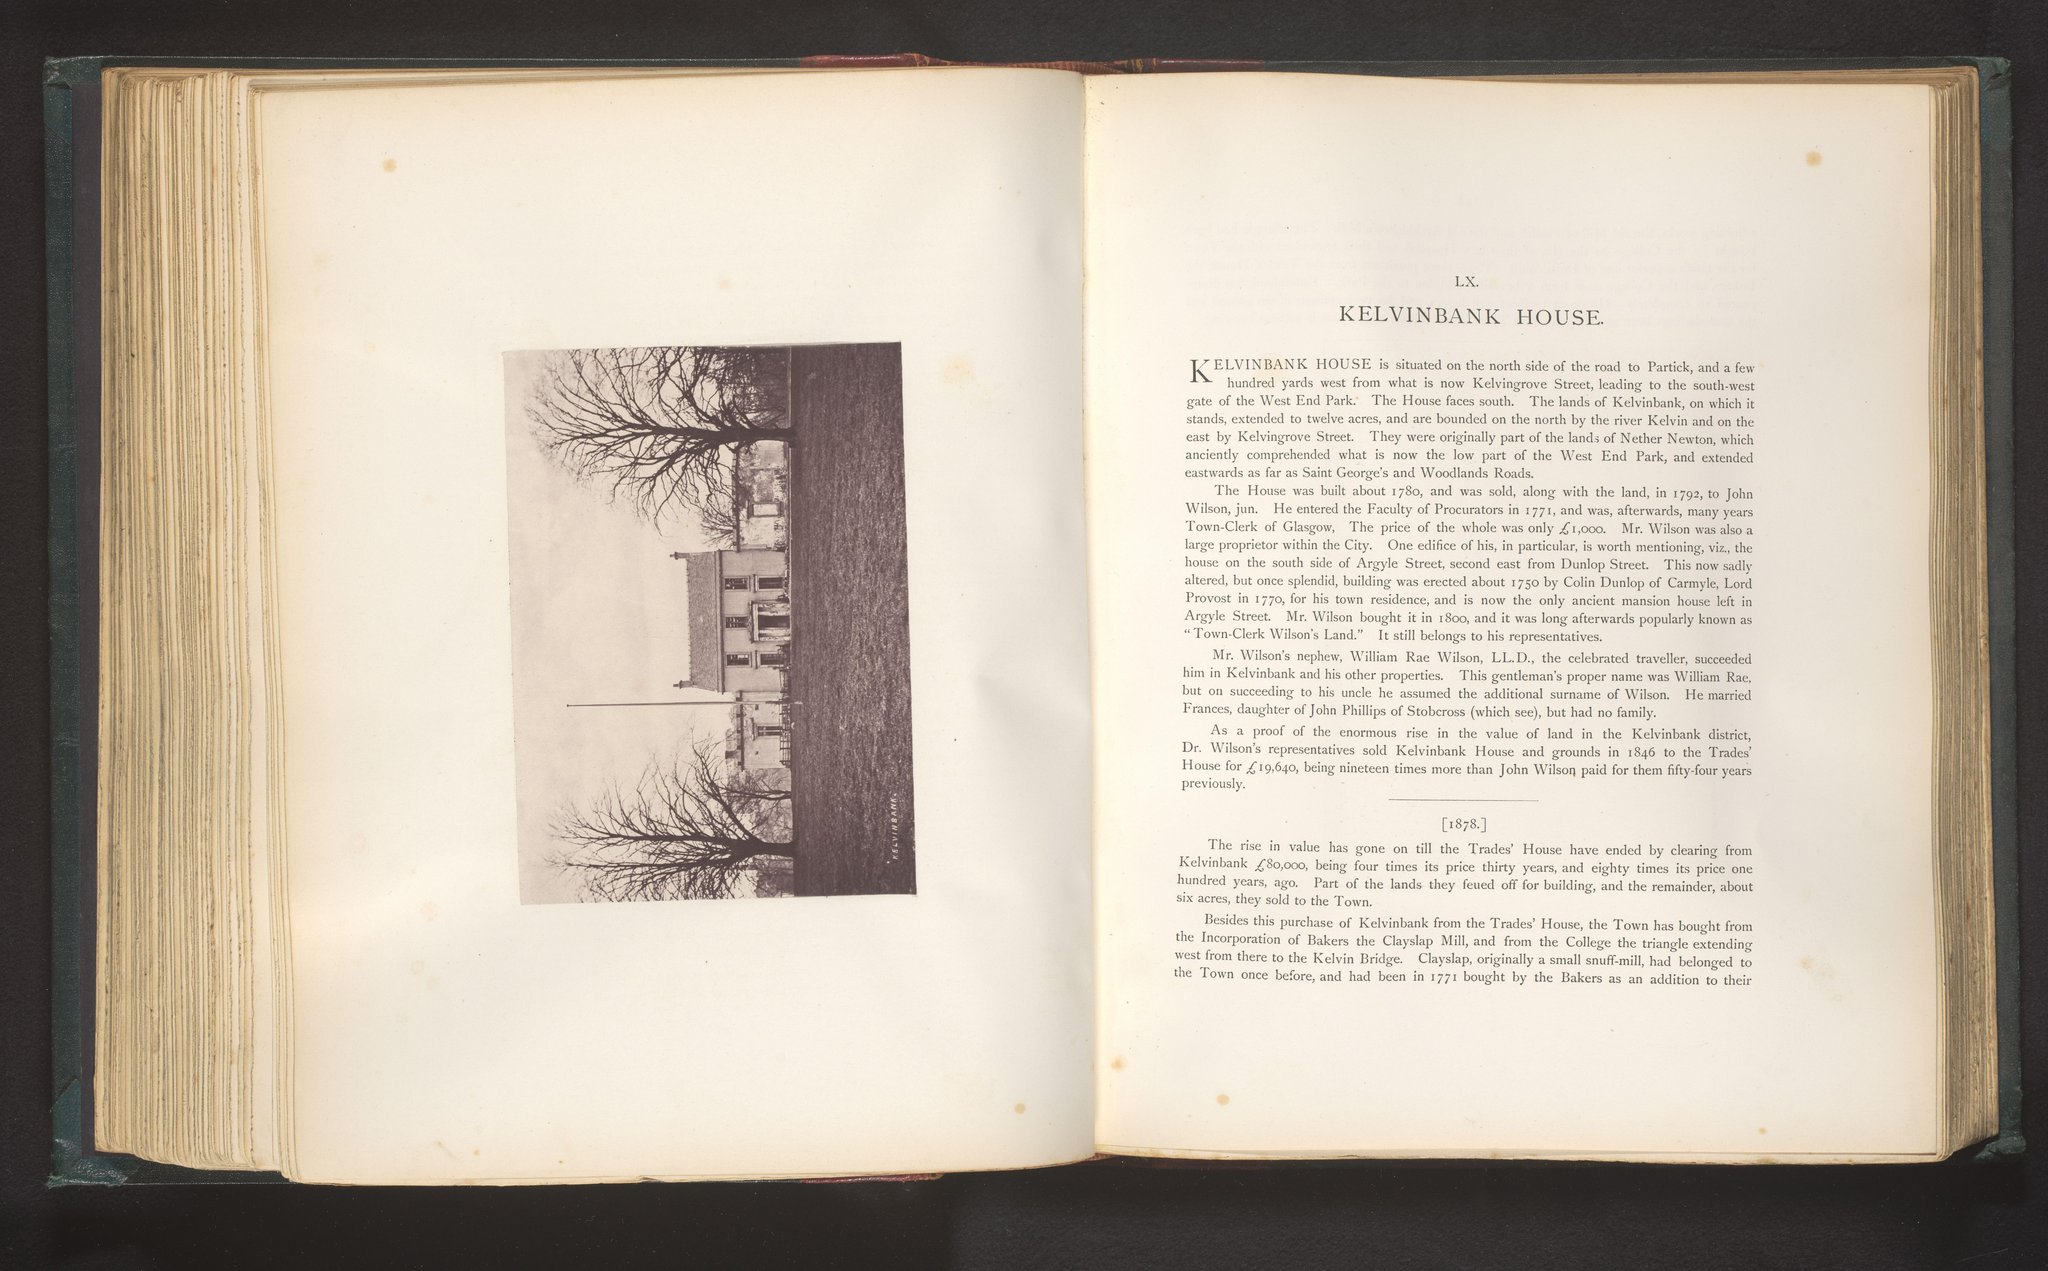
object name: page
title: Kelvinbank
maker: thomas annan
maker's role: fotograaf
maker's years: 1829-1887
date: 1868-1878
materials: paper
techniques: carbon print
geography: glasgow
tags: rural housing, e.g. country-house, villa, cottage, façade (of house or building)